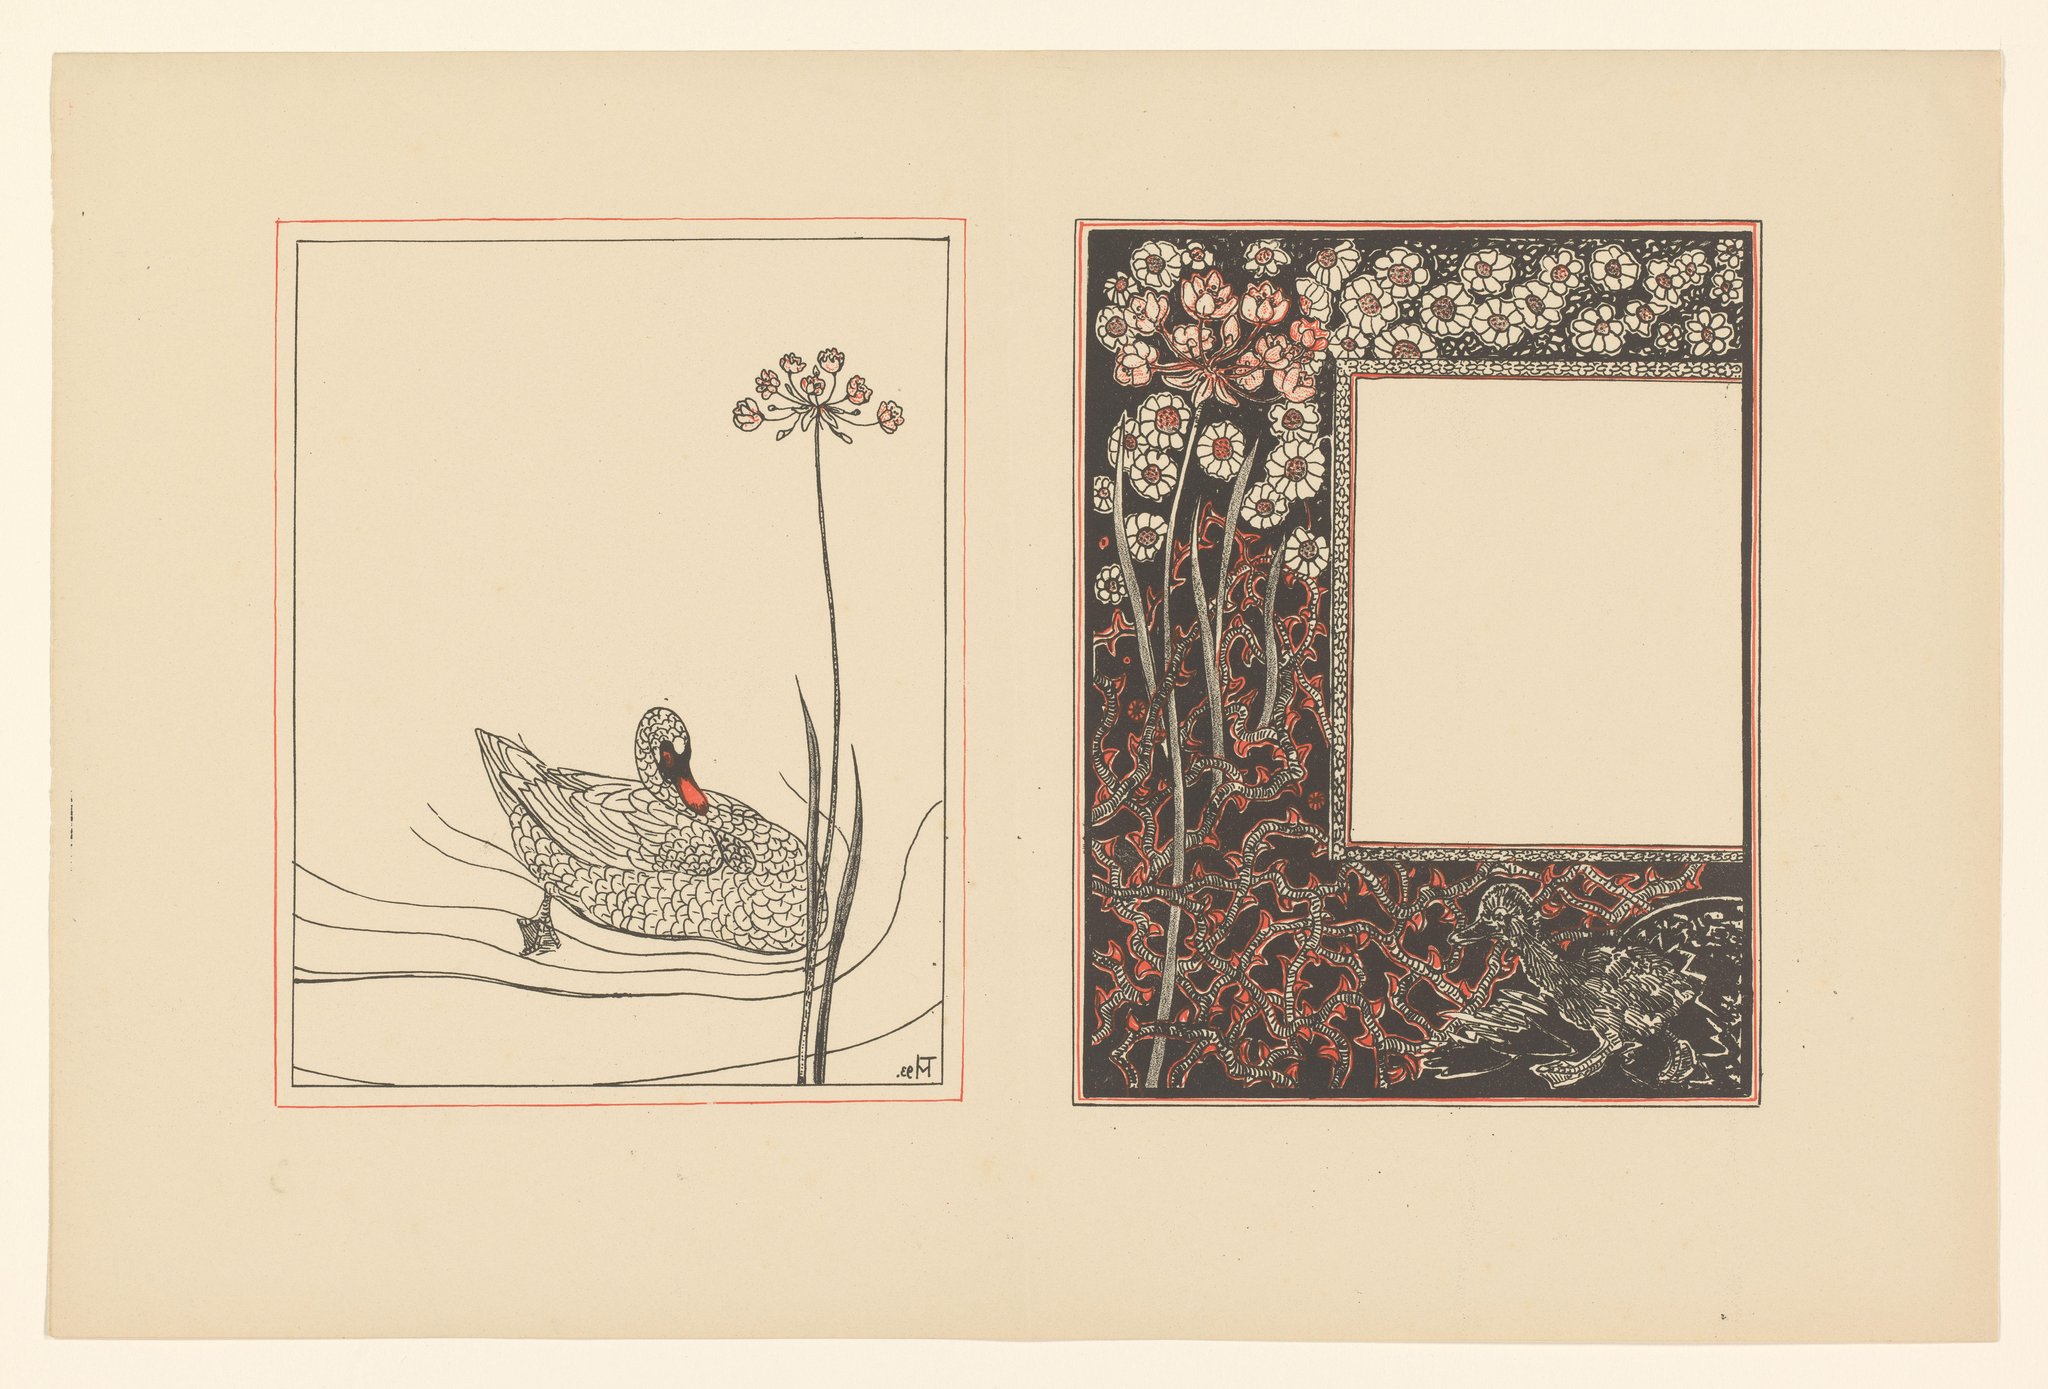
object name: wrapper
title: Omslag voor: Theo van Hoytema, Het leelijke jonge eendje, 1893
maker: theo van hoytema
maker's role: draughtsman, painter, print maker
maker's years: 1863-1917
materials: paper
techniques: lithograph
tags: flowers, water-birds: swan, eggs, egg-dishes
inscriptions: collector's mark: Lugt 2760, collector's mark: Lugt 2228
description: In het linker kader een zwemmende zwaan en een bloem. In het rechter kader bloemen en doorns; rechtsonder komt een kuiken uit een ei.